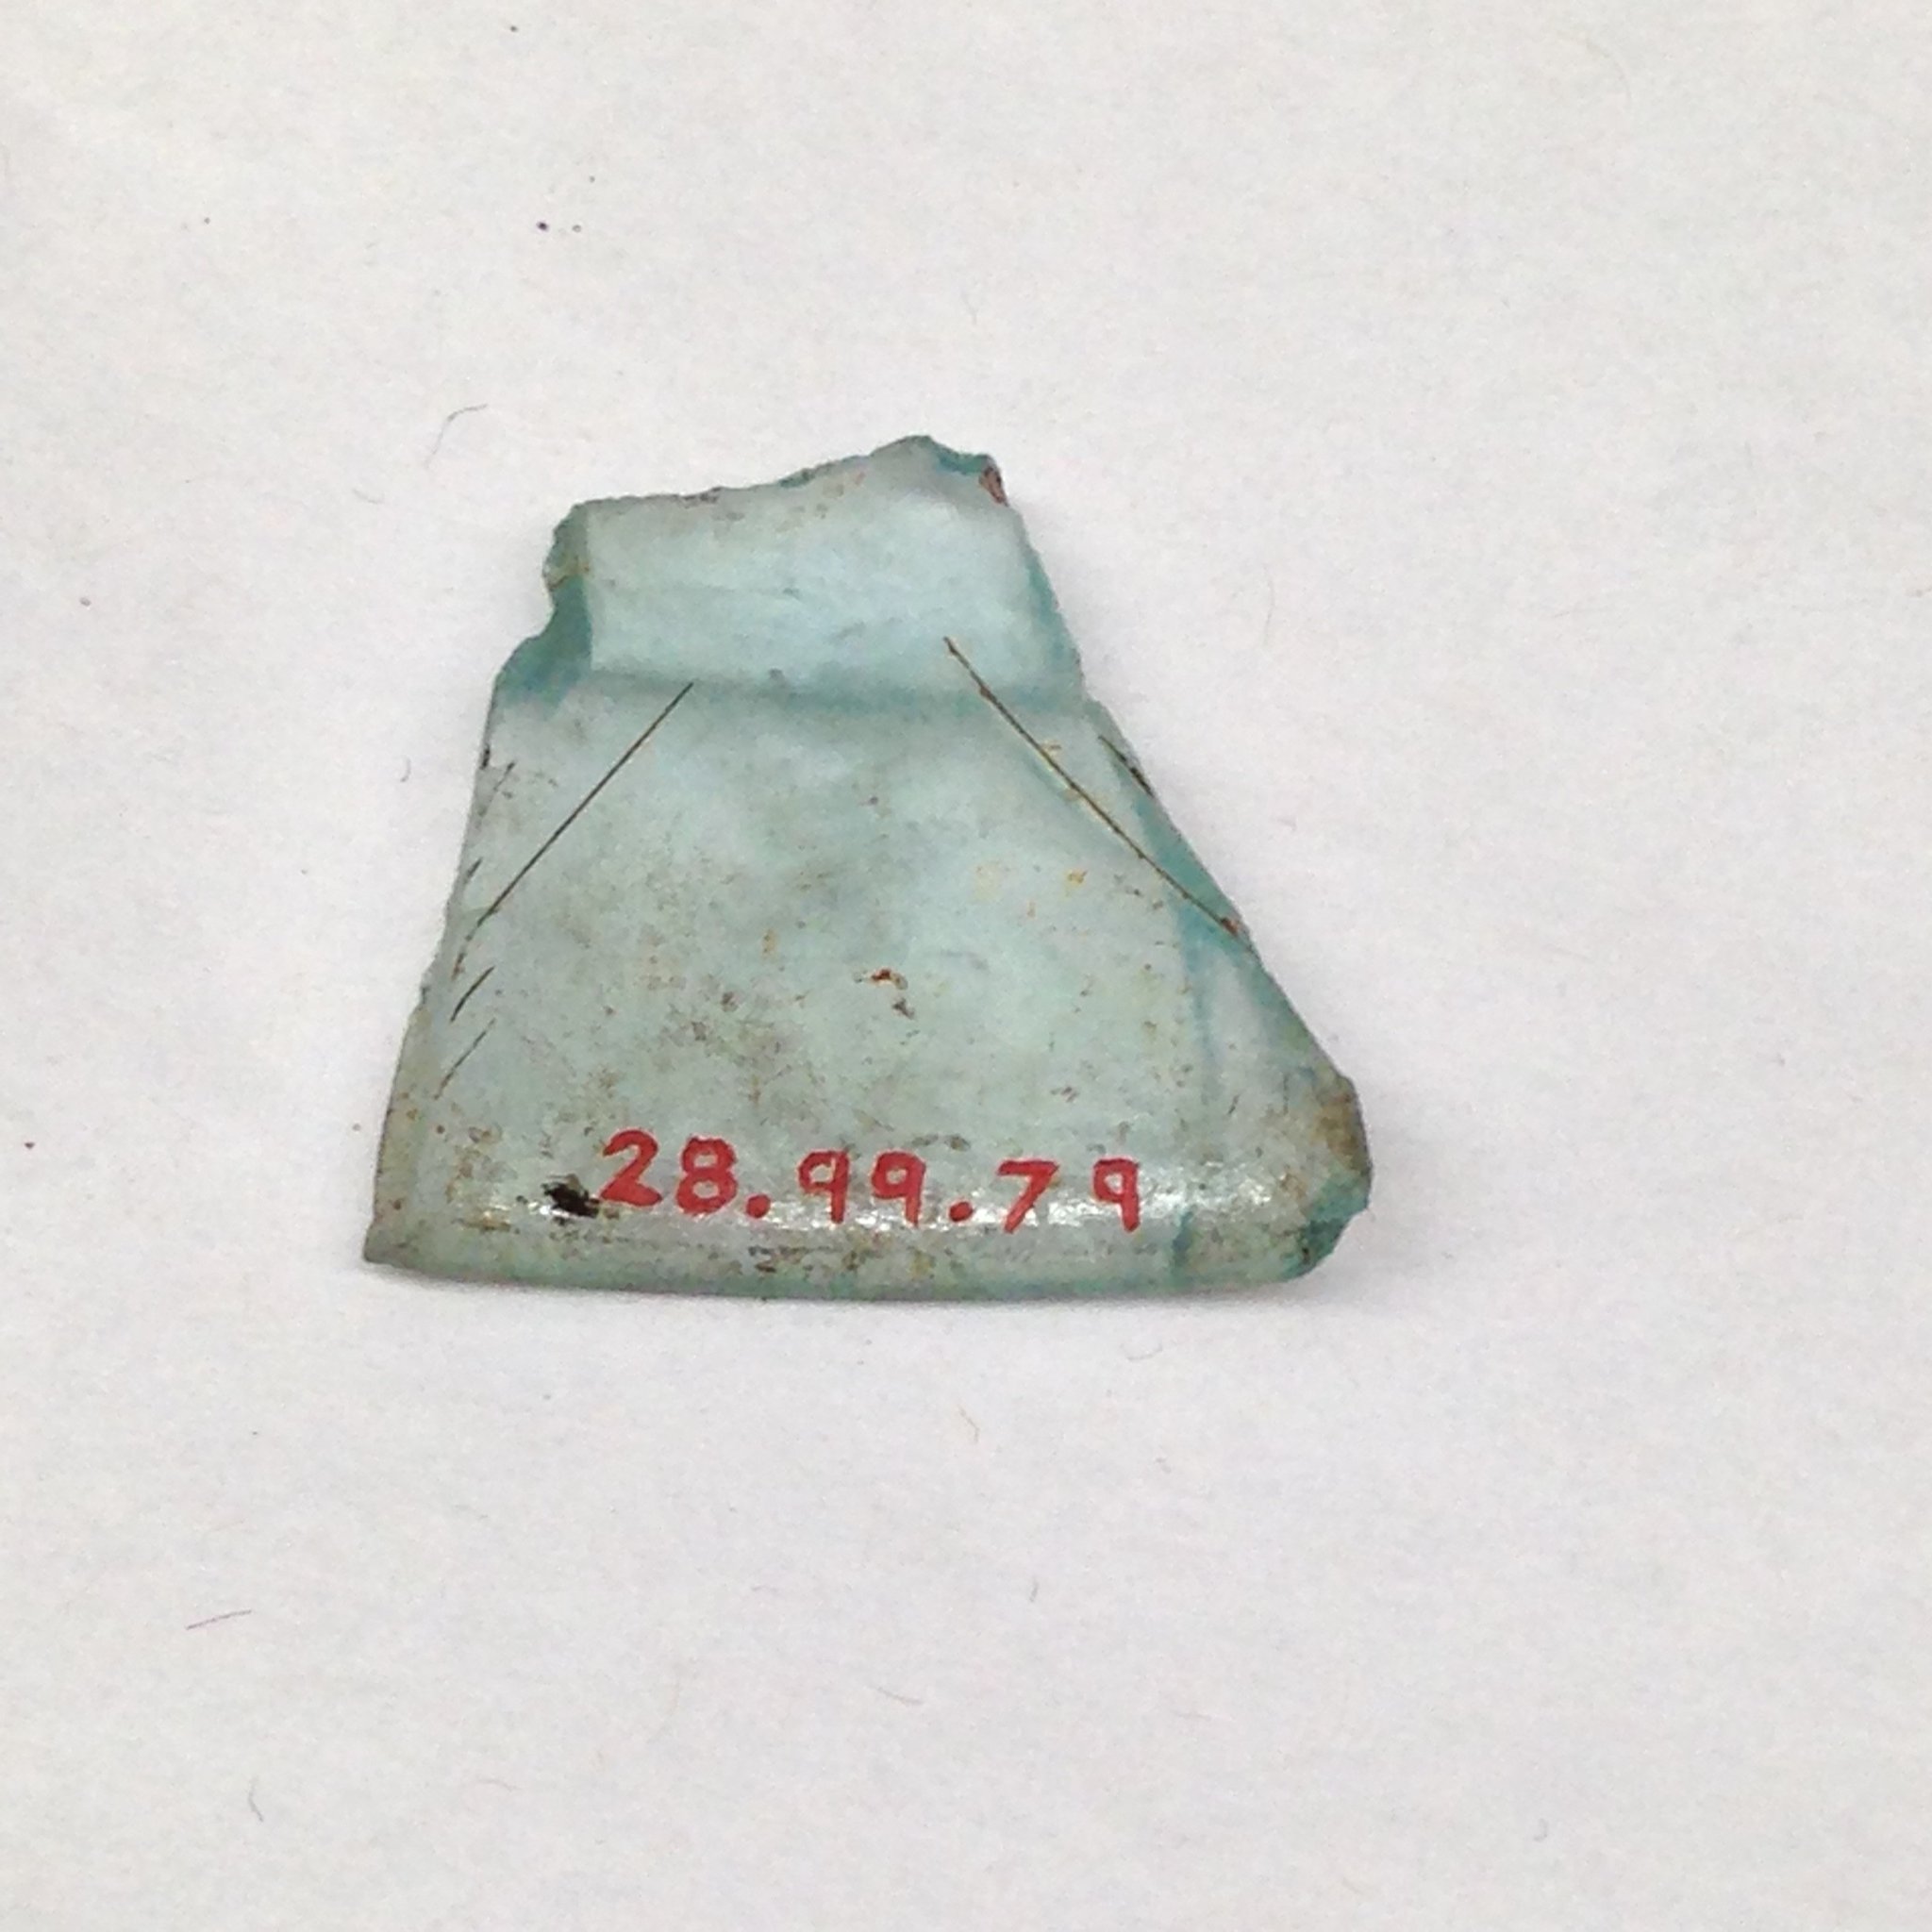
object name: fragment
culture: european or middle eastern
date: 1150-1250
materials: ceramic, glass